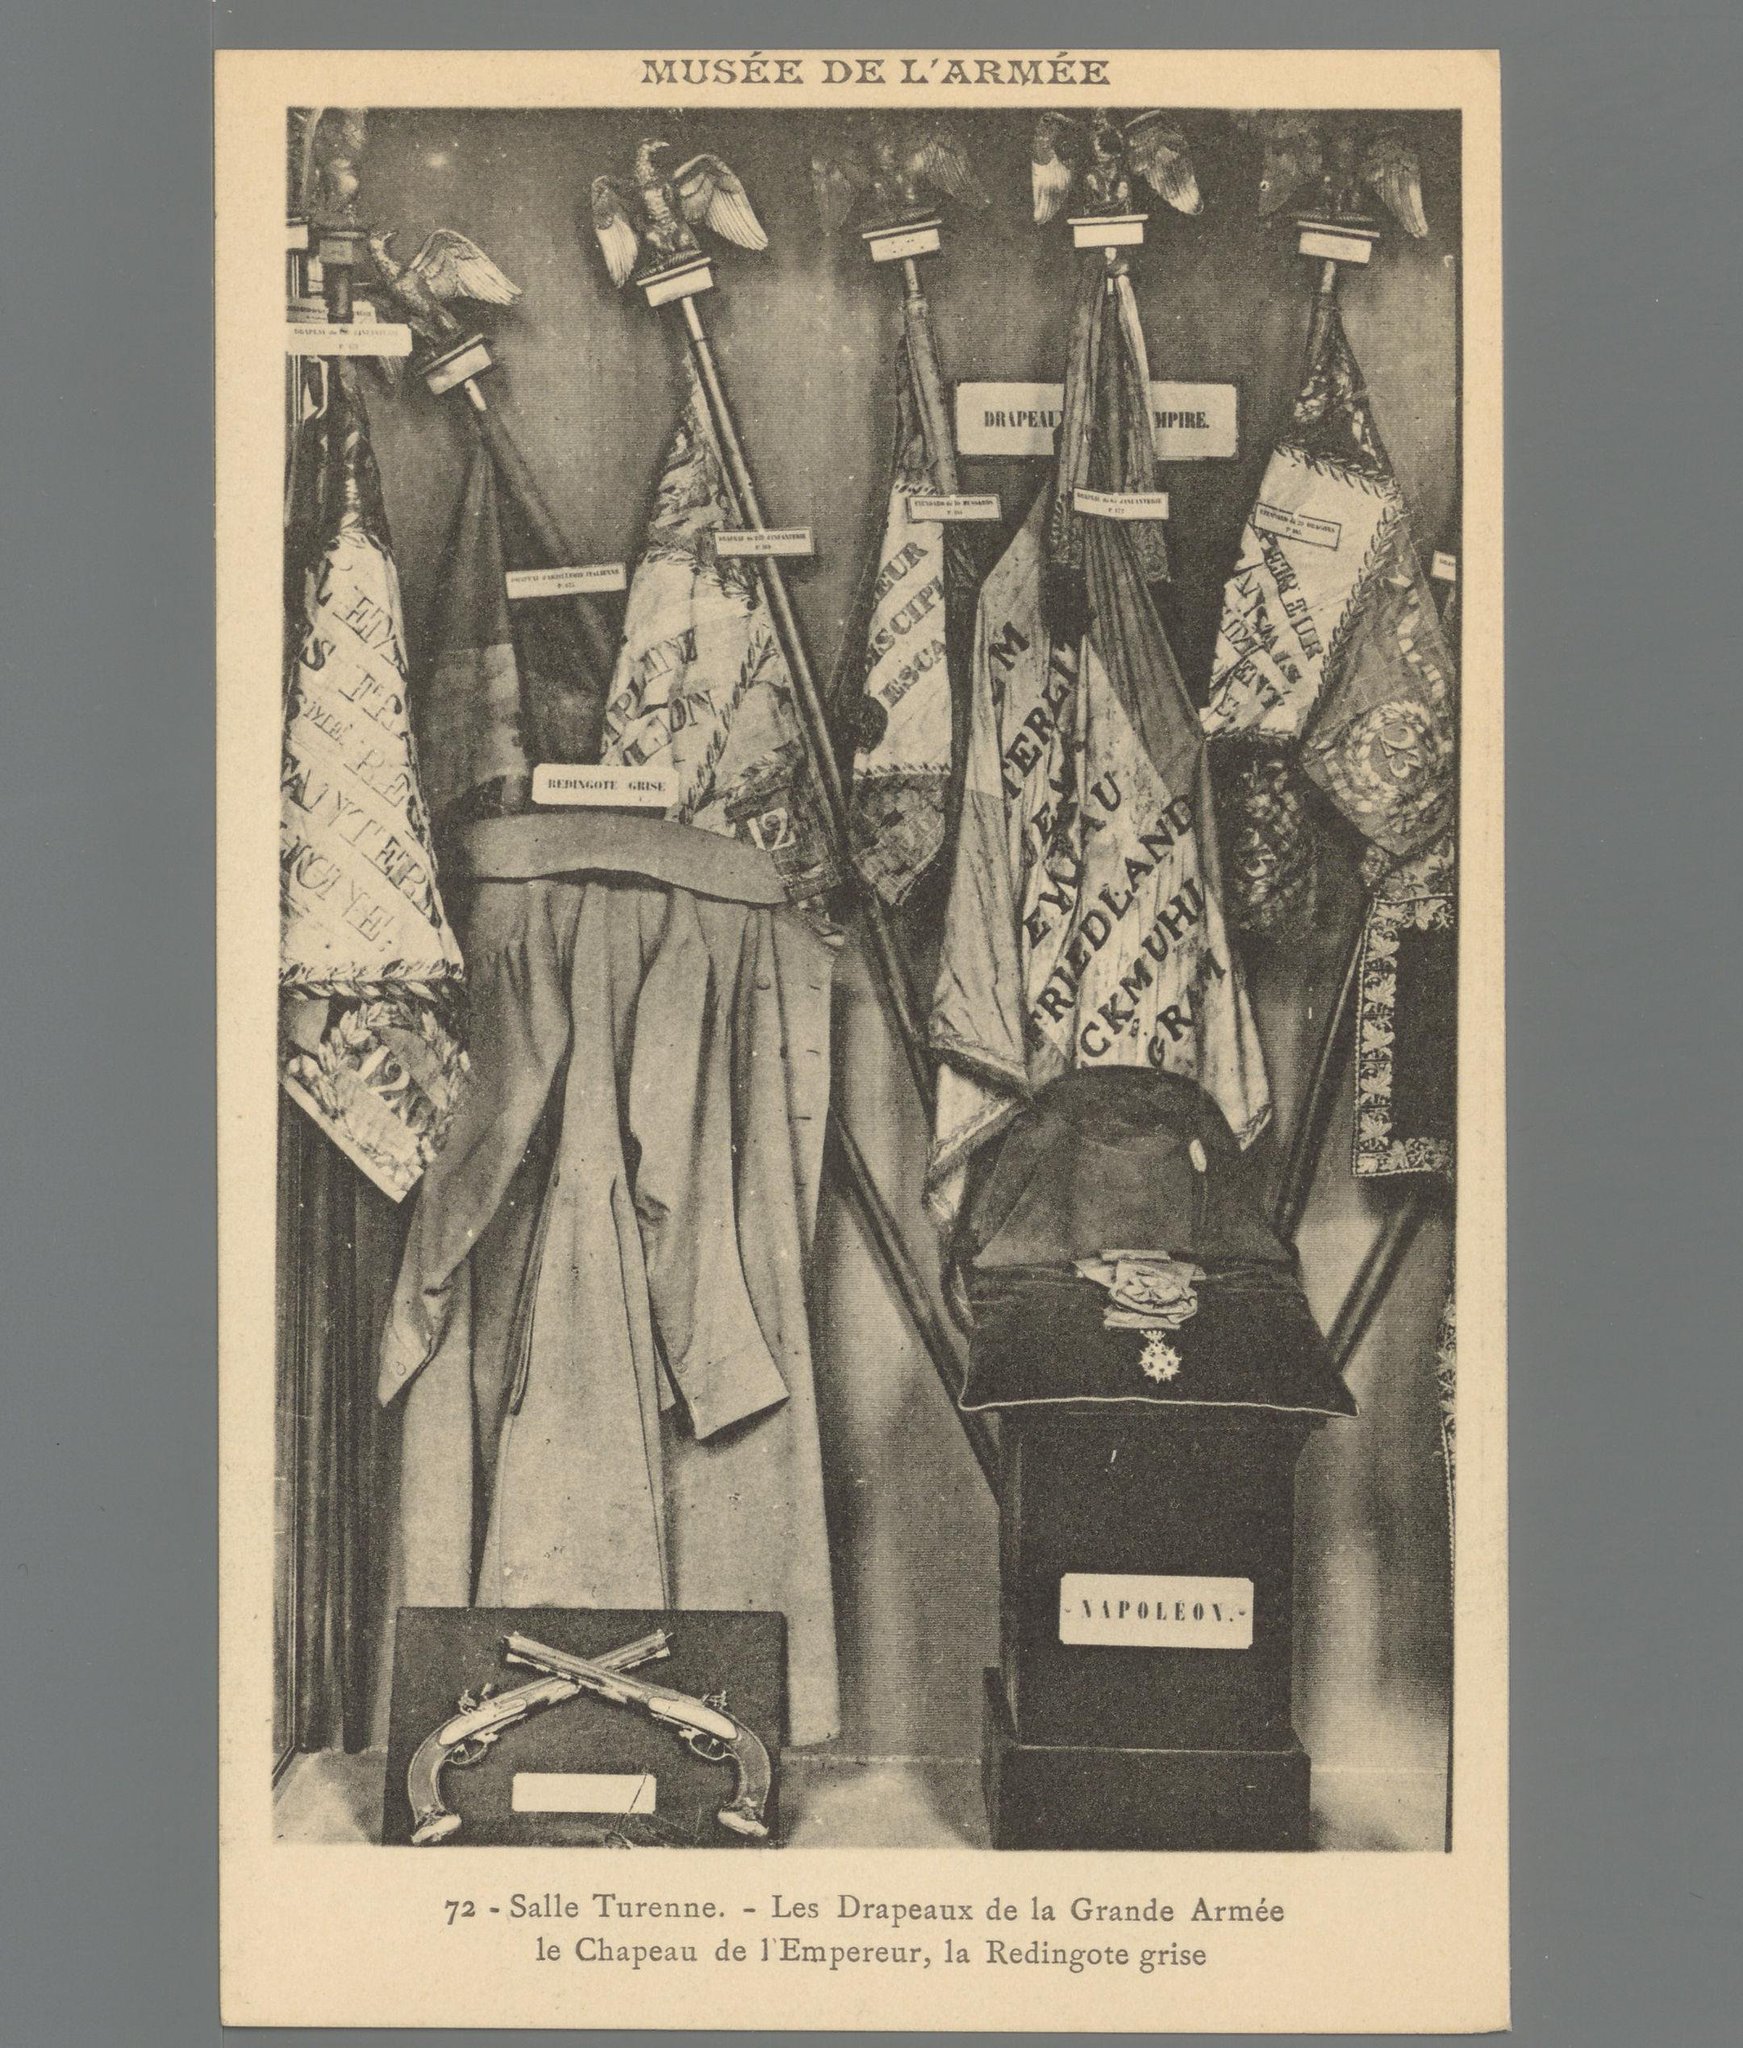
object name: photomechanical print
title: Musée de l'Armée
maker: Anonymous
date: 1903-1920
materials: cardboard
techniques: photograph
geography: paris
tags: permanent exhibition, museum, coat, cape, (military) flags and standards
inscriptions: stamp: ‘Inter Arma Caritas. Société de Secours aux Blessés Militaires. 19 Rue Matignon. Paris’